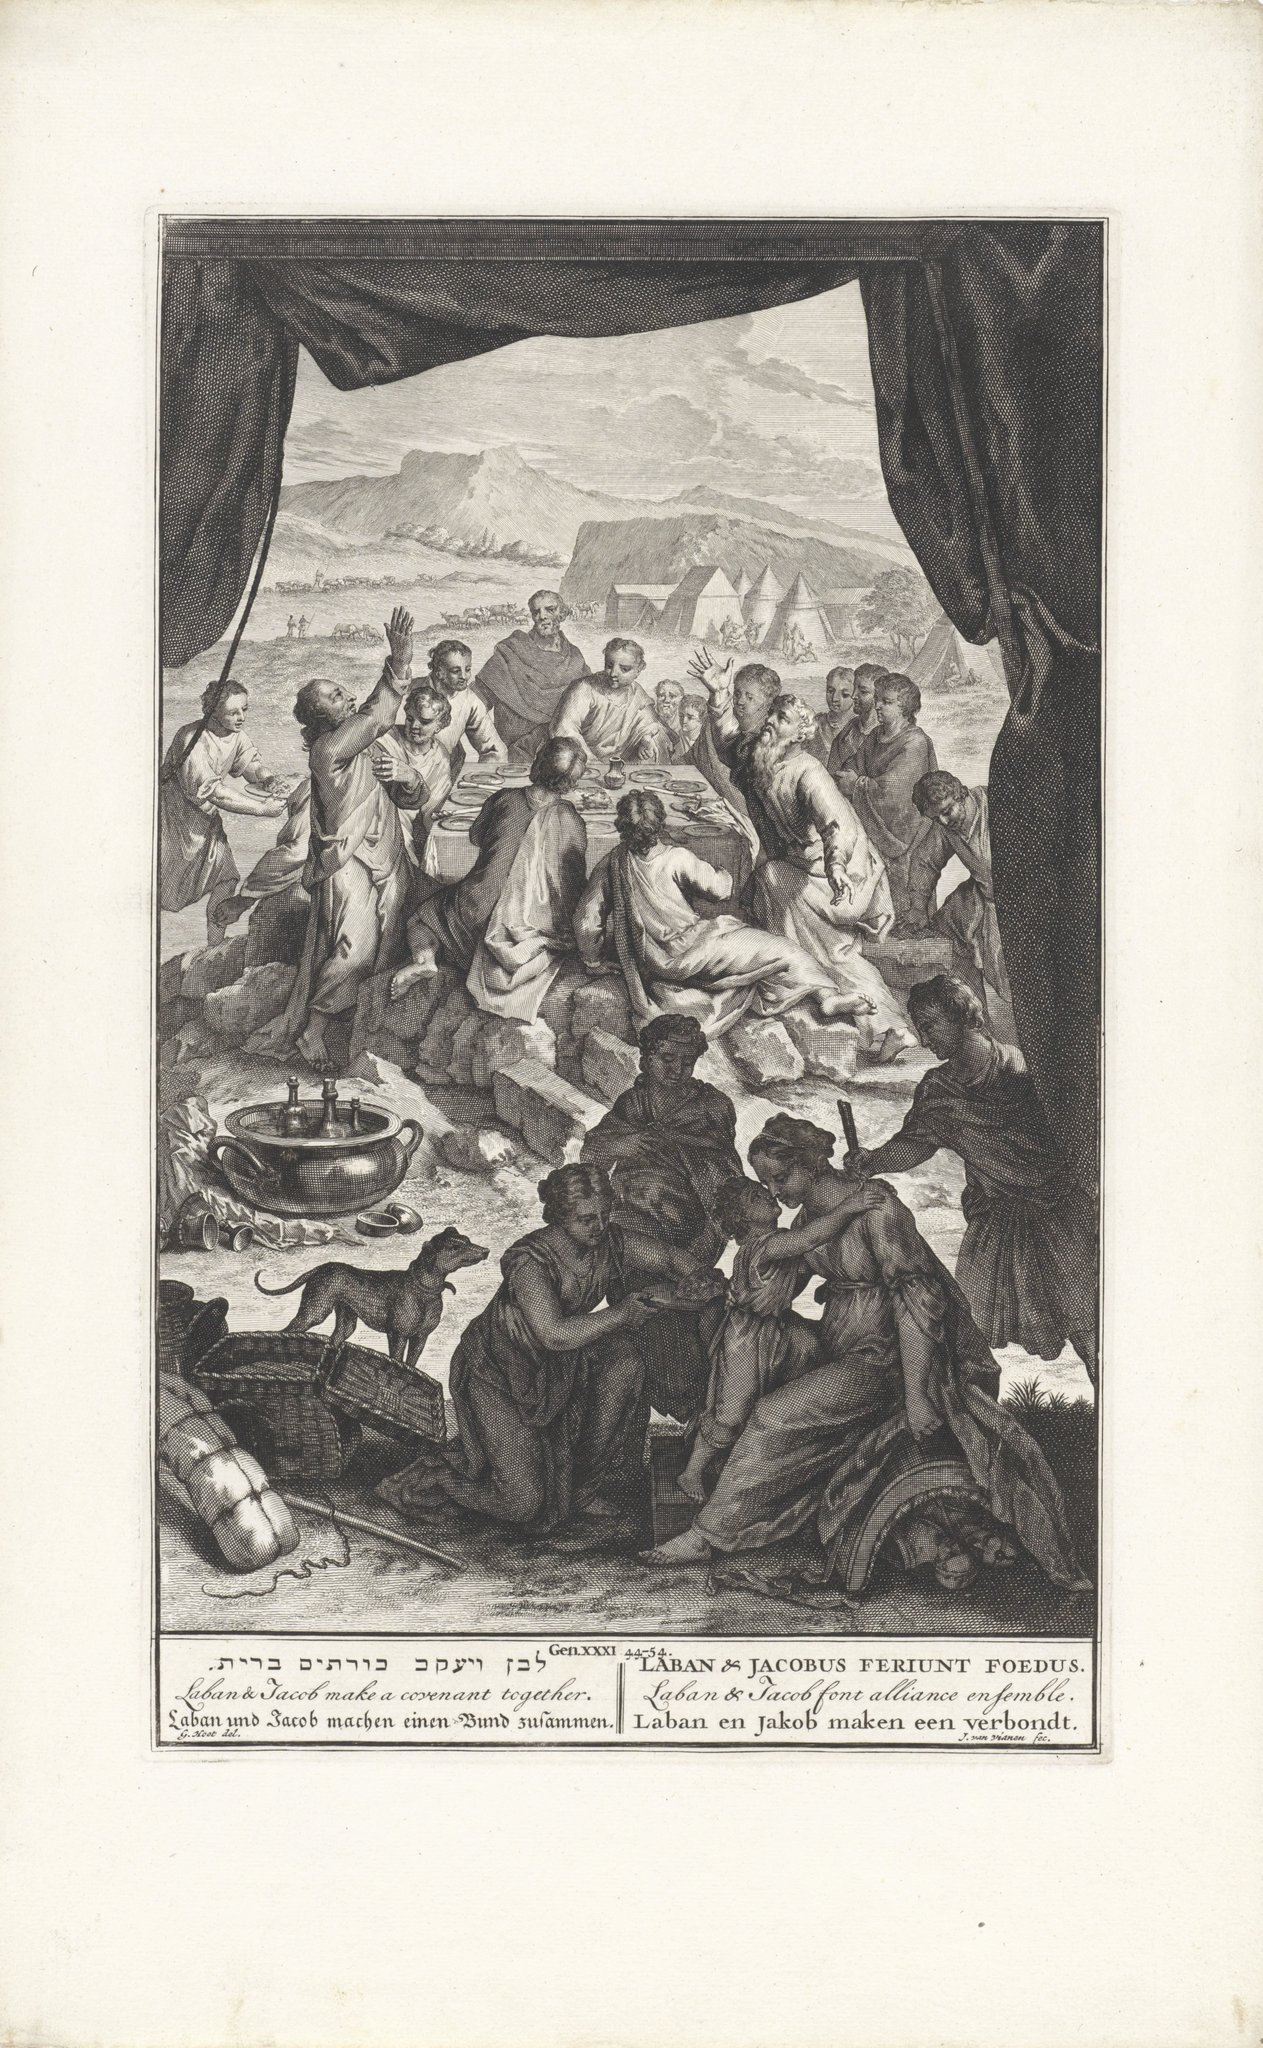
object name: book illustration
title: Laban en Jakob sluiten een verbond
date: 1705-1720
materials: paper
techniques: engraving, etching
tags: the partnership with laban ~ story of jacob (genesis 30:25-43)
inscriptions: collector's mark: Lugt 2228, inscription: ‘Utrechts Fundatie huijs’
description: Prent oorspronkelijk bedoeld voor: Figures de la Bible. Amsterdam: Bernard Picart, 1720. Prent ook gebruikt in: Taferelen der voornaamste geschiedenissen van het Oude en Nieuwe Testament (...) door de vermaarde kunstenaars Hoet, Houbraken, en Picart getekent (...) en met beschrijvingen uitgebreid. Den Haag: Pieter de Hondt, 1728.